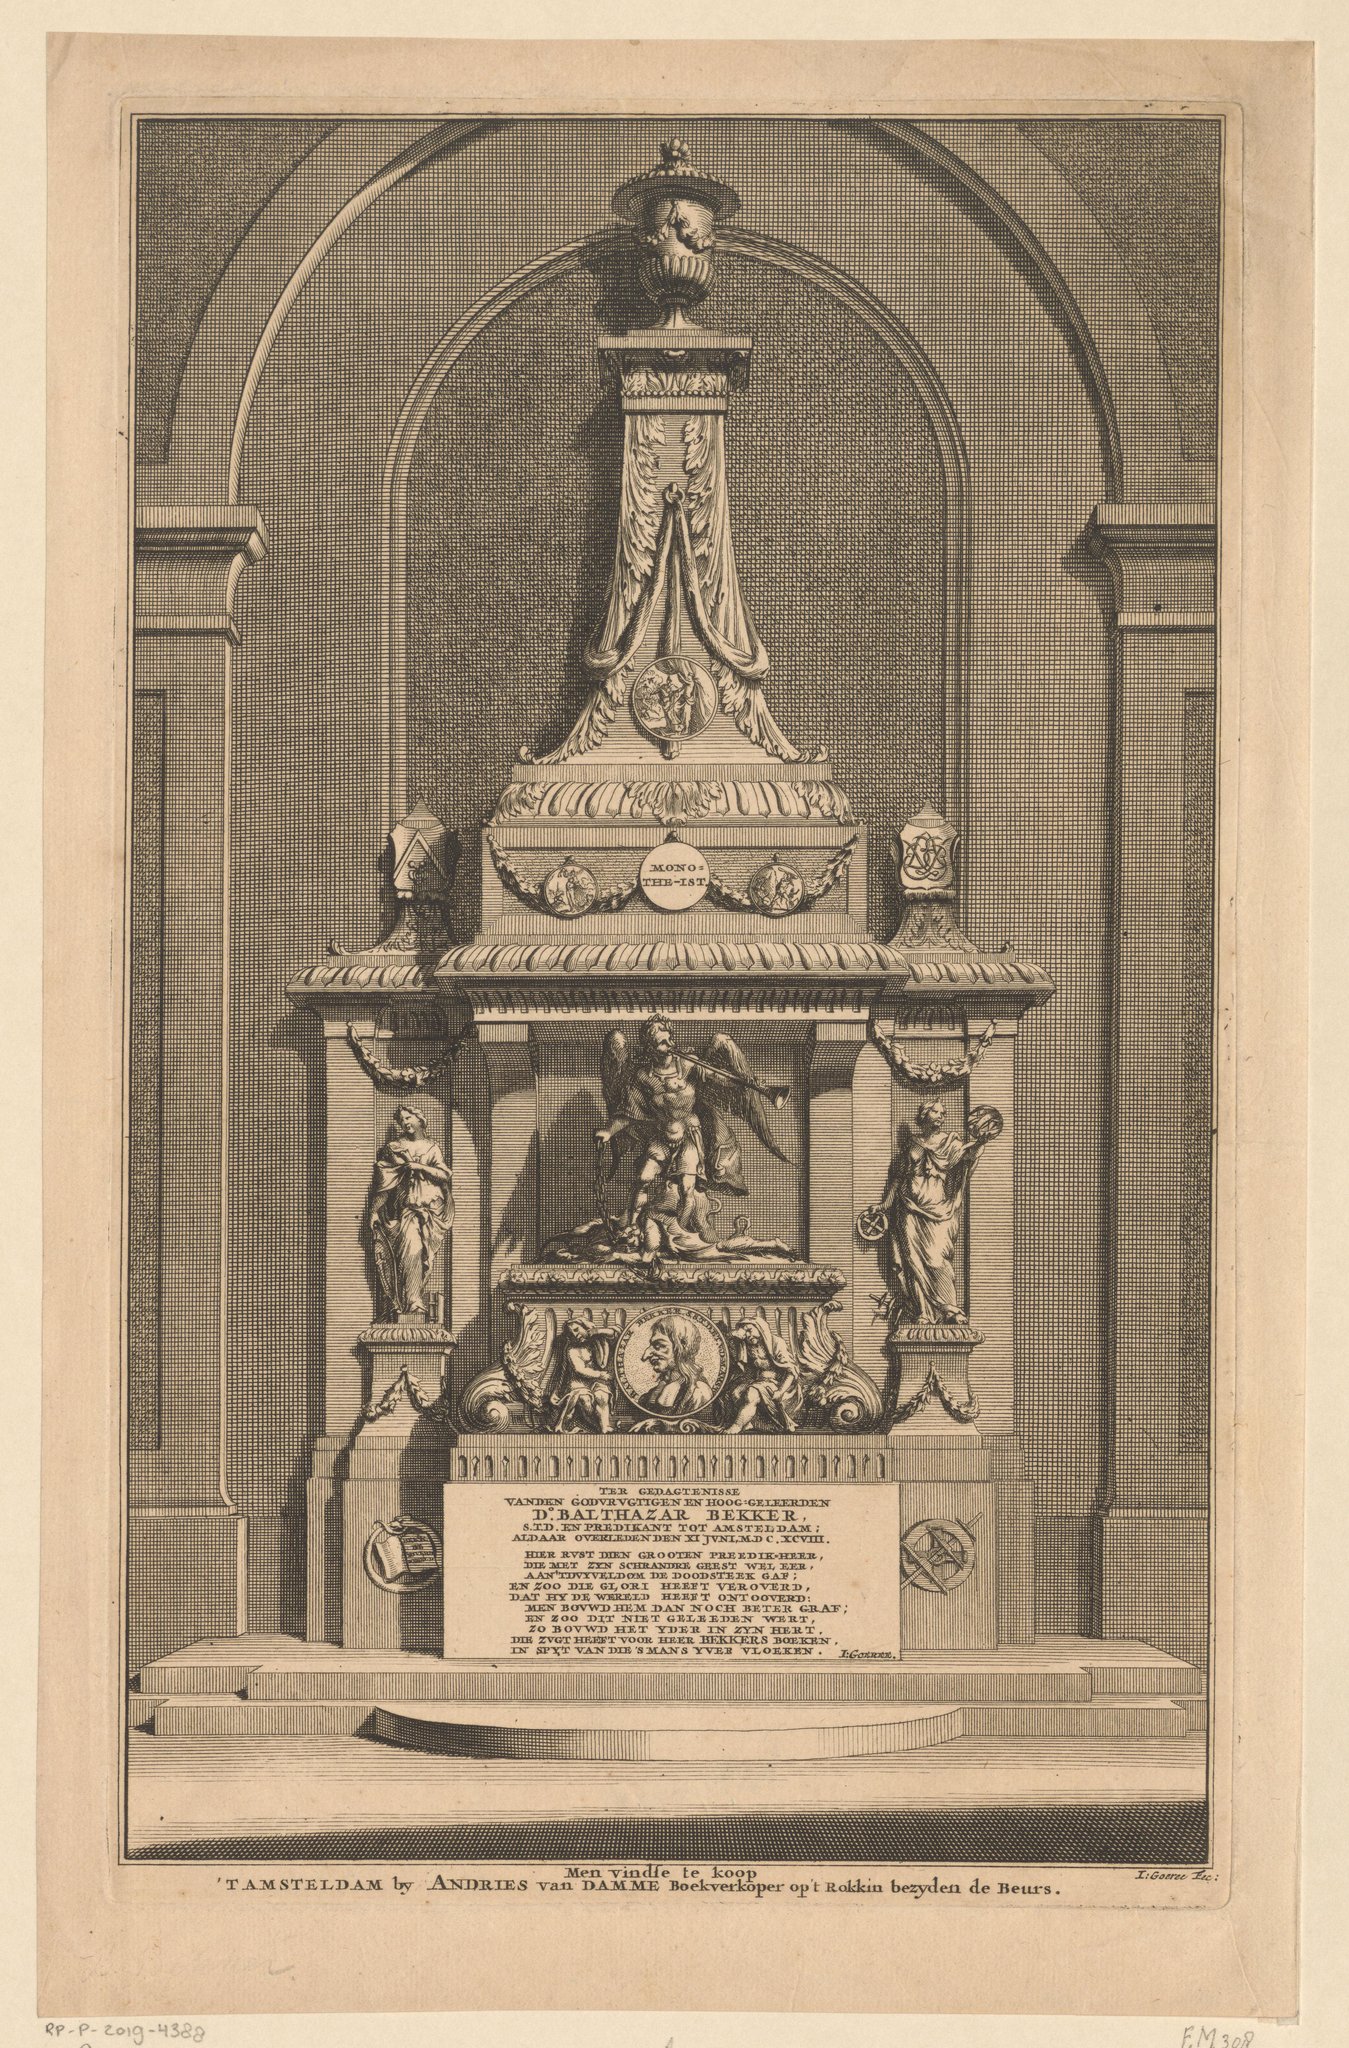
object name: print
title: Grafmonument van Balthasar Bekker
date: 1698-1727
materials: paper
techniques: engraving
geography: amsterdam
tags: amsterdam, balthasar bekker, grave-building, monumental tomb, grave, tomb and other grave-forms and grave-markers